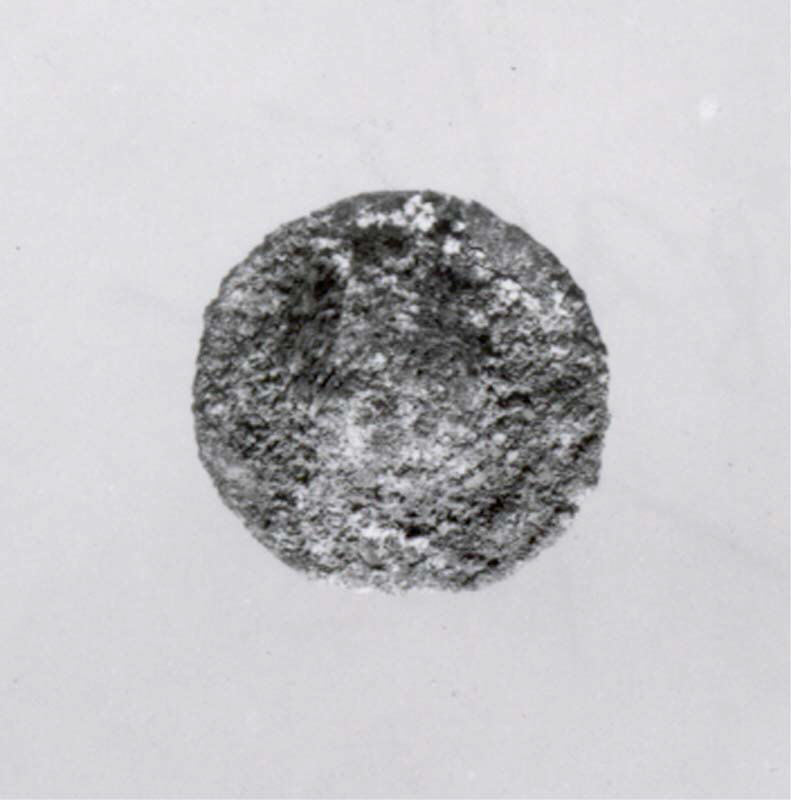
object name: stud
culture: iranian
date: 900-801 BCE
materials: bronze, copper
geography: iran